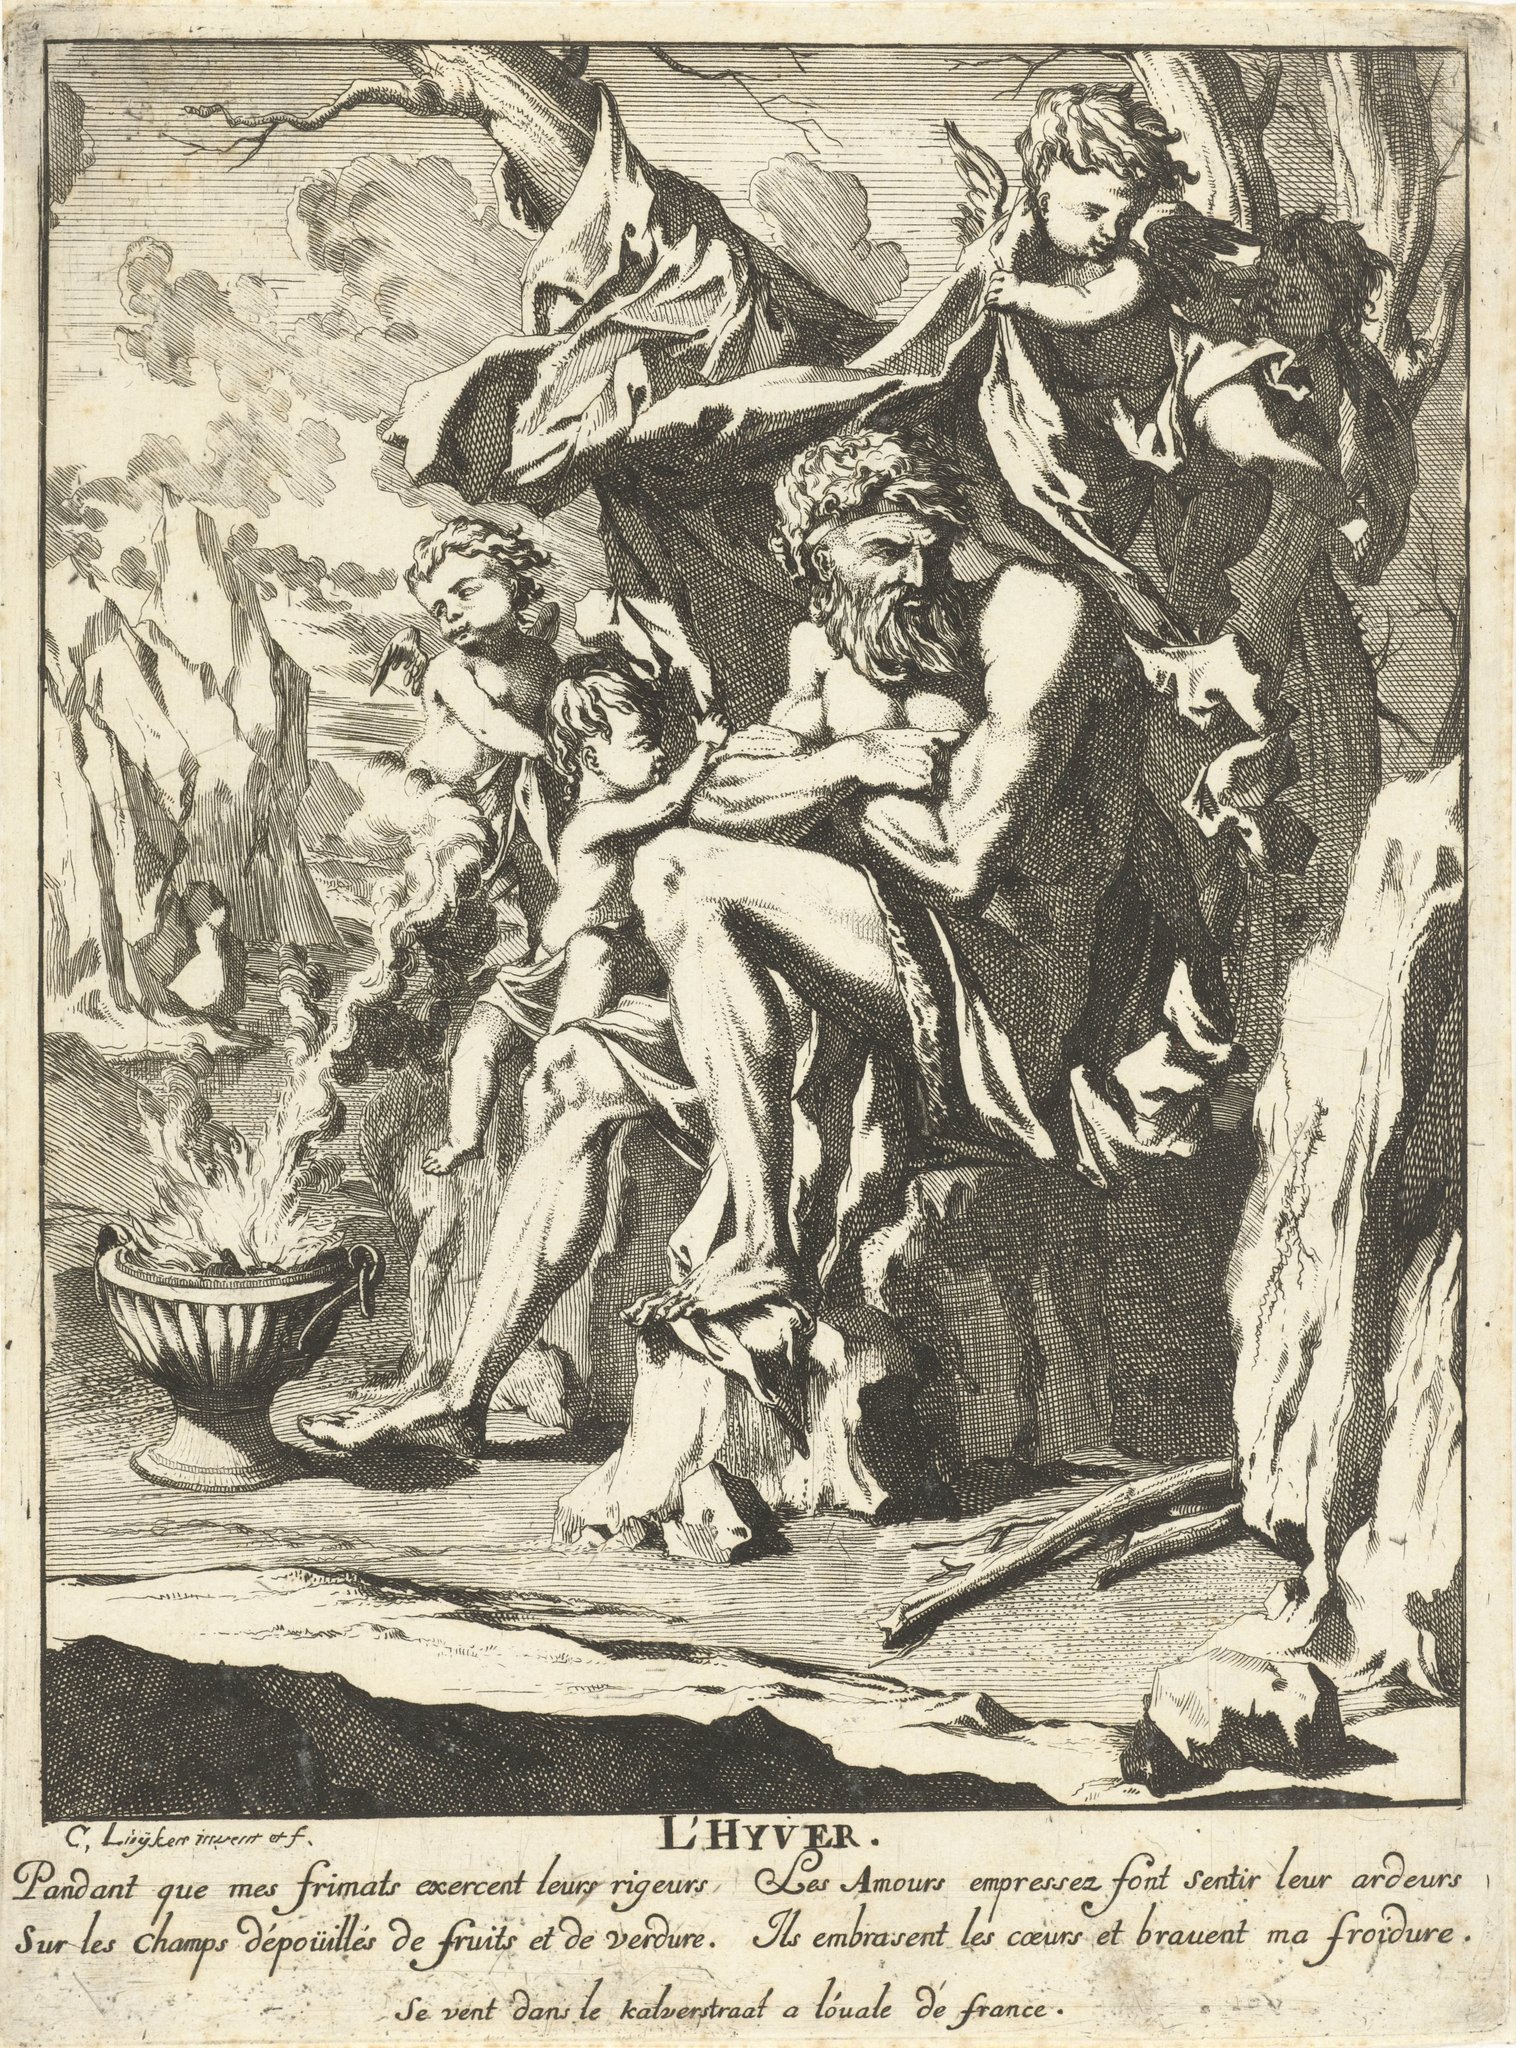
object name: print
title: L'Hyver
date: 1698-1708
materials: paper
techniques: etching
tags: winter, 'hyems'; 'inverno' (ripa)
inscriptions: collector's mark: Lugt 2228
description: Een naakte oude man zit ineengedoken bij een brandende vuurpot. Vier engelen proberen hem met een groot kleed te beschutten. In de marge een vierregelig Frans vers op de winter. De prent maakt deel uit van een vierdelige serie met voorstellingen van de vier jaargetijden.